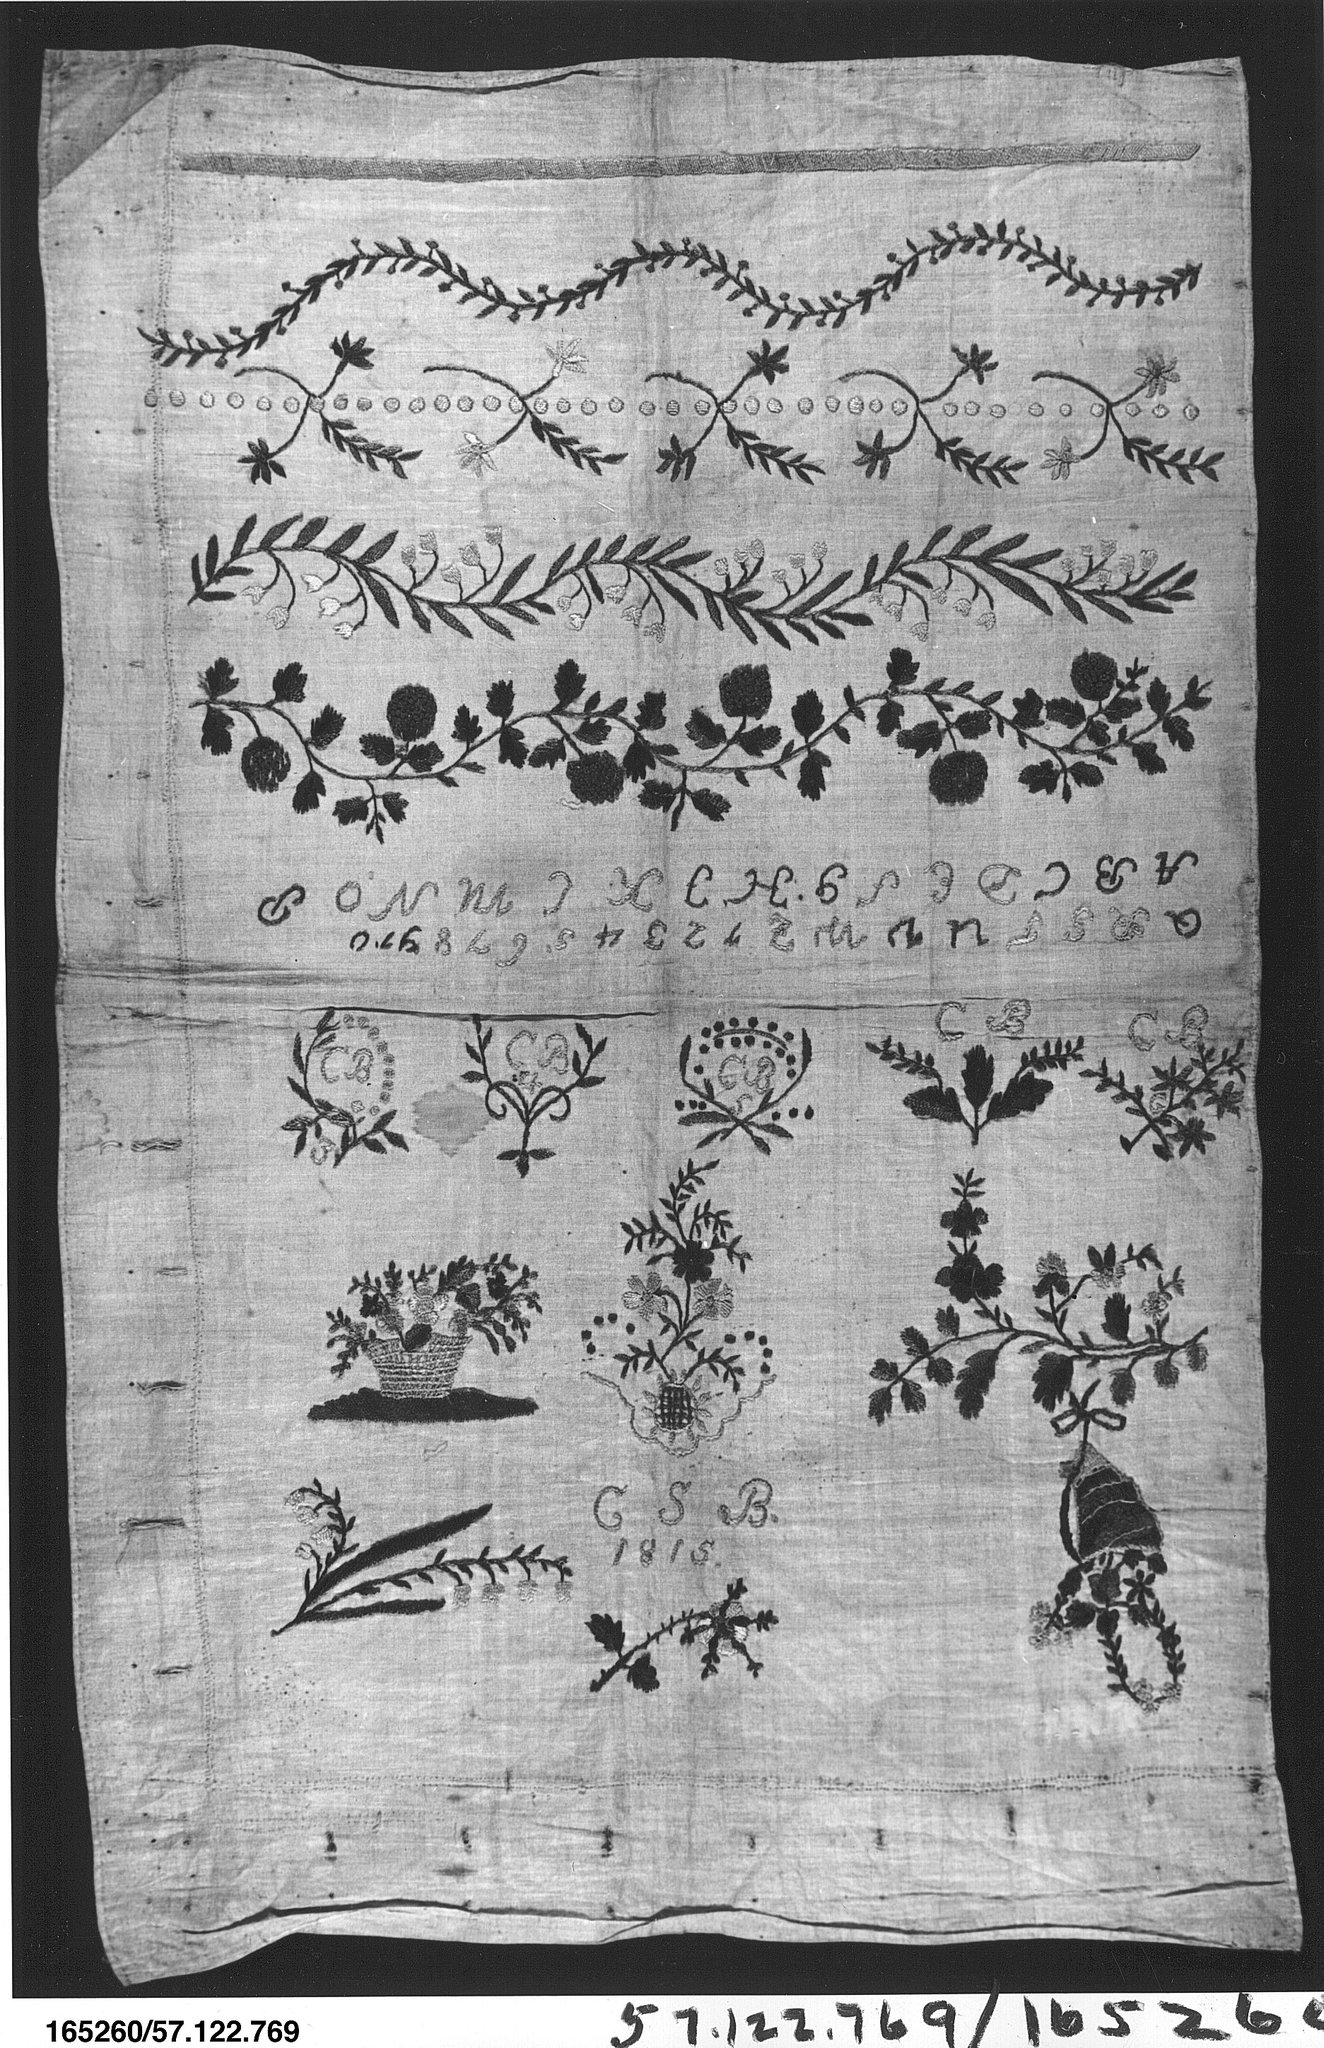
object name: sampler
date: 1815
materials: linen, silk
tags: flowers